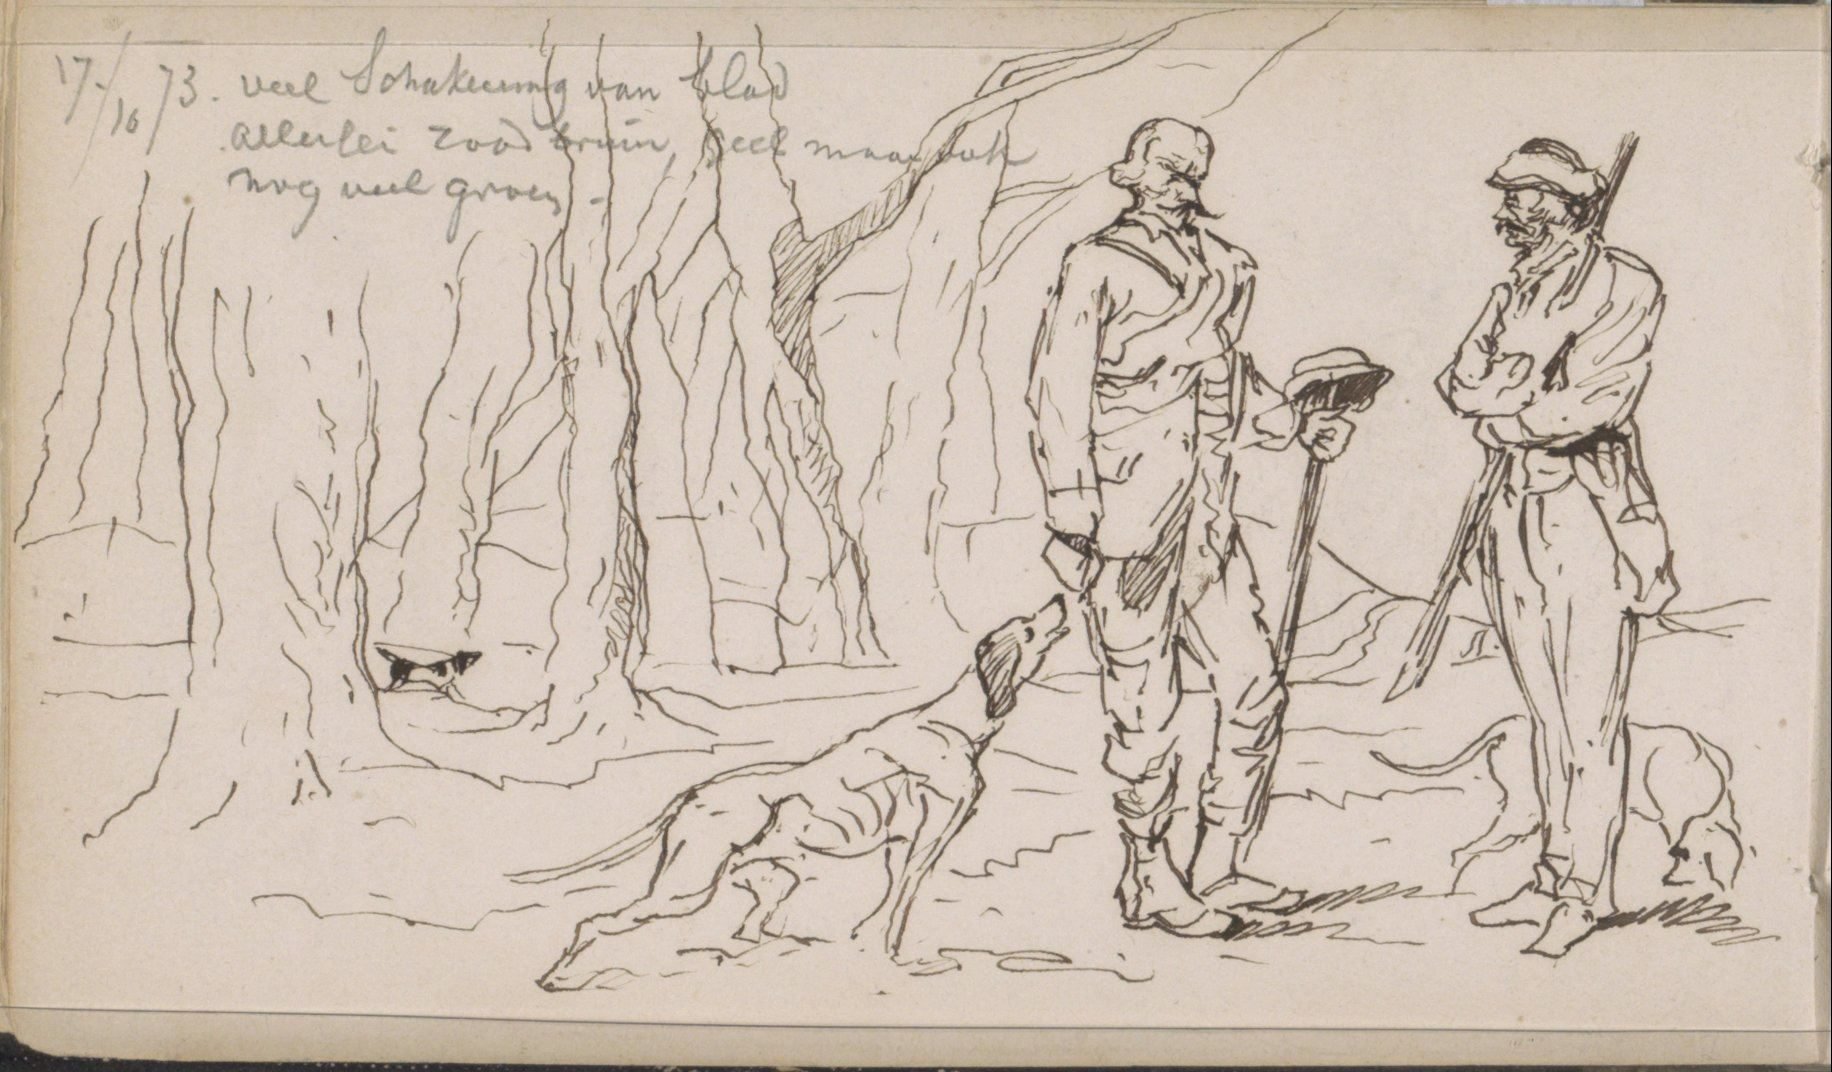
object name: sketchbook leaf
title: Haagse Bos en twee jagers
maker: johannes tavenraat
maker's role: draughtsman, painter, print maker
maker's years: 1809-1881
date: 1810-1873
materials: ink, paper, pencil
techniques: pen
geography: the hague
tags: hunter, forest, wood, firearms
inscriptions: date: ‘17/10 73.’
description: Blad 6 verso en 7 recto uit een schetsboek met 46 bladen.